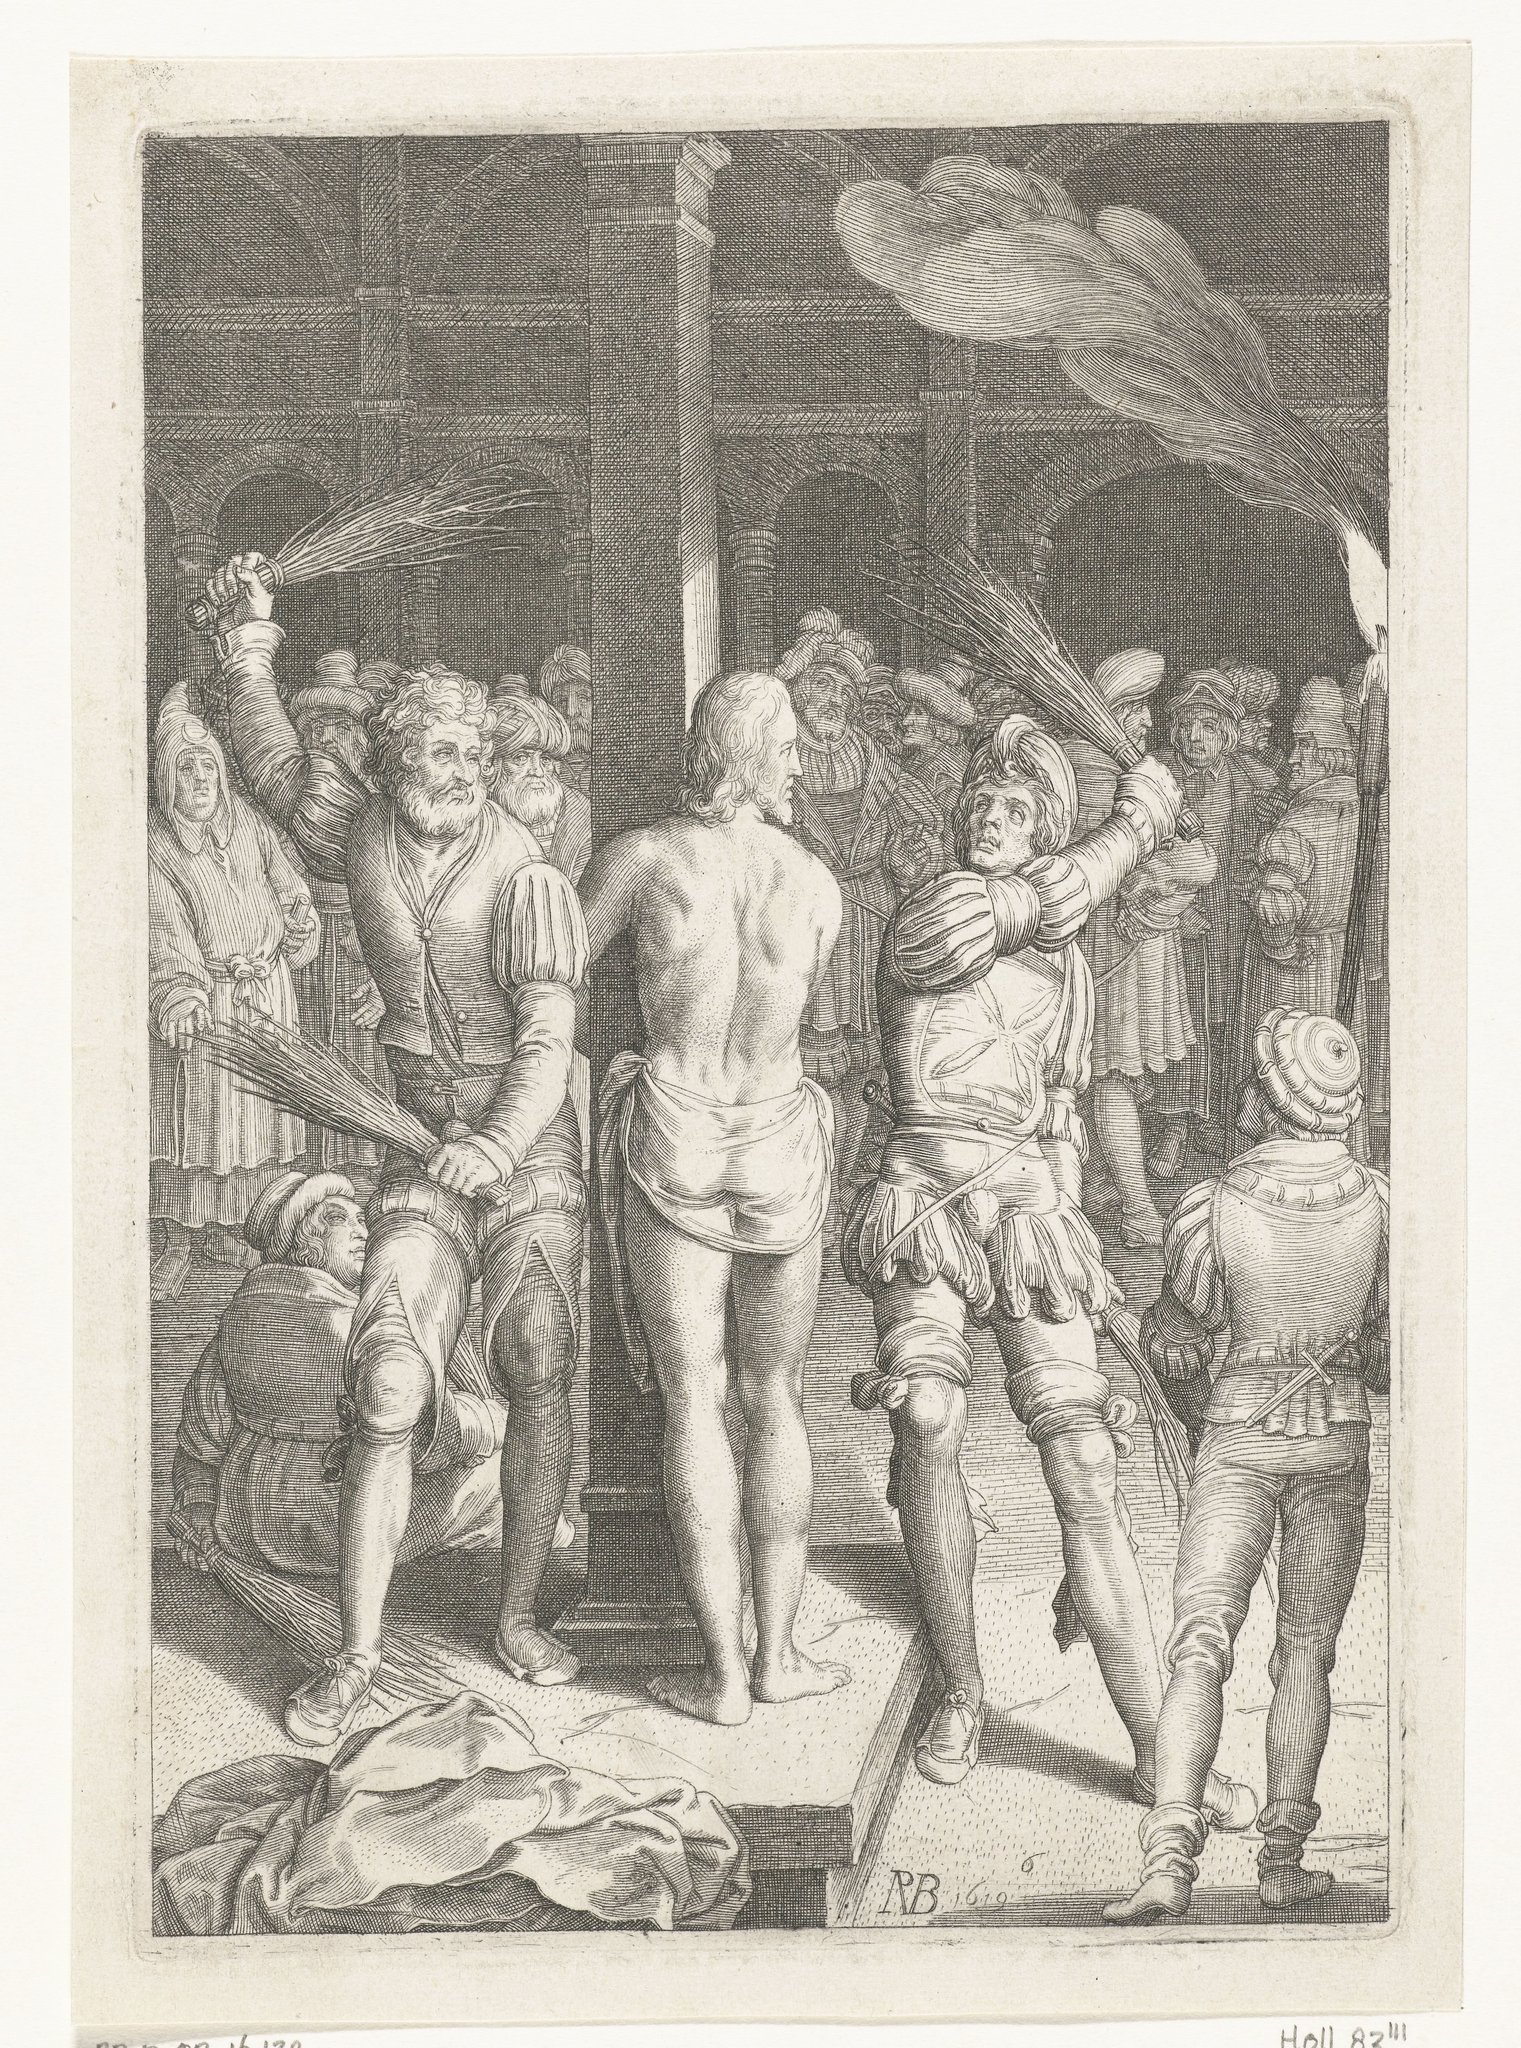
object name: print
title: Geseling van Christus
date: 1619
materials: paper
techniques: engraving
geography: netherlands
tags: flagellation by soldiers, christ usually tied to a column (matthew 27:26; mark 15:15; john 19:1)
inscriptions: collector's mark: Lugt 2228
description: Prent uit serie van twaalf prenten met scènes uit de Passie. Reeks geïnspireerd door de prenten van Hendrick Goltzius en Lucas van Leyden.